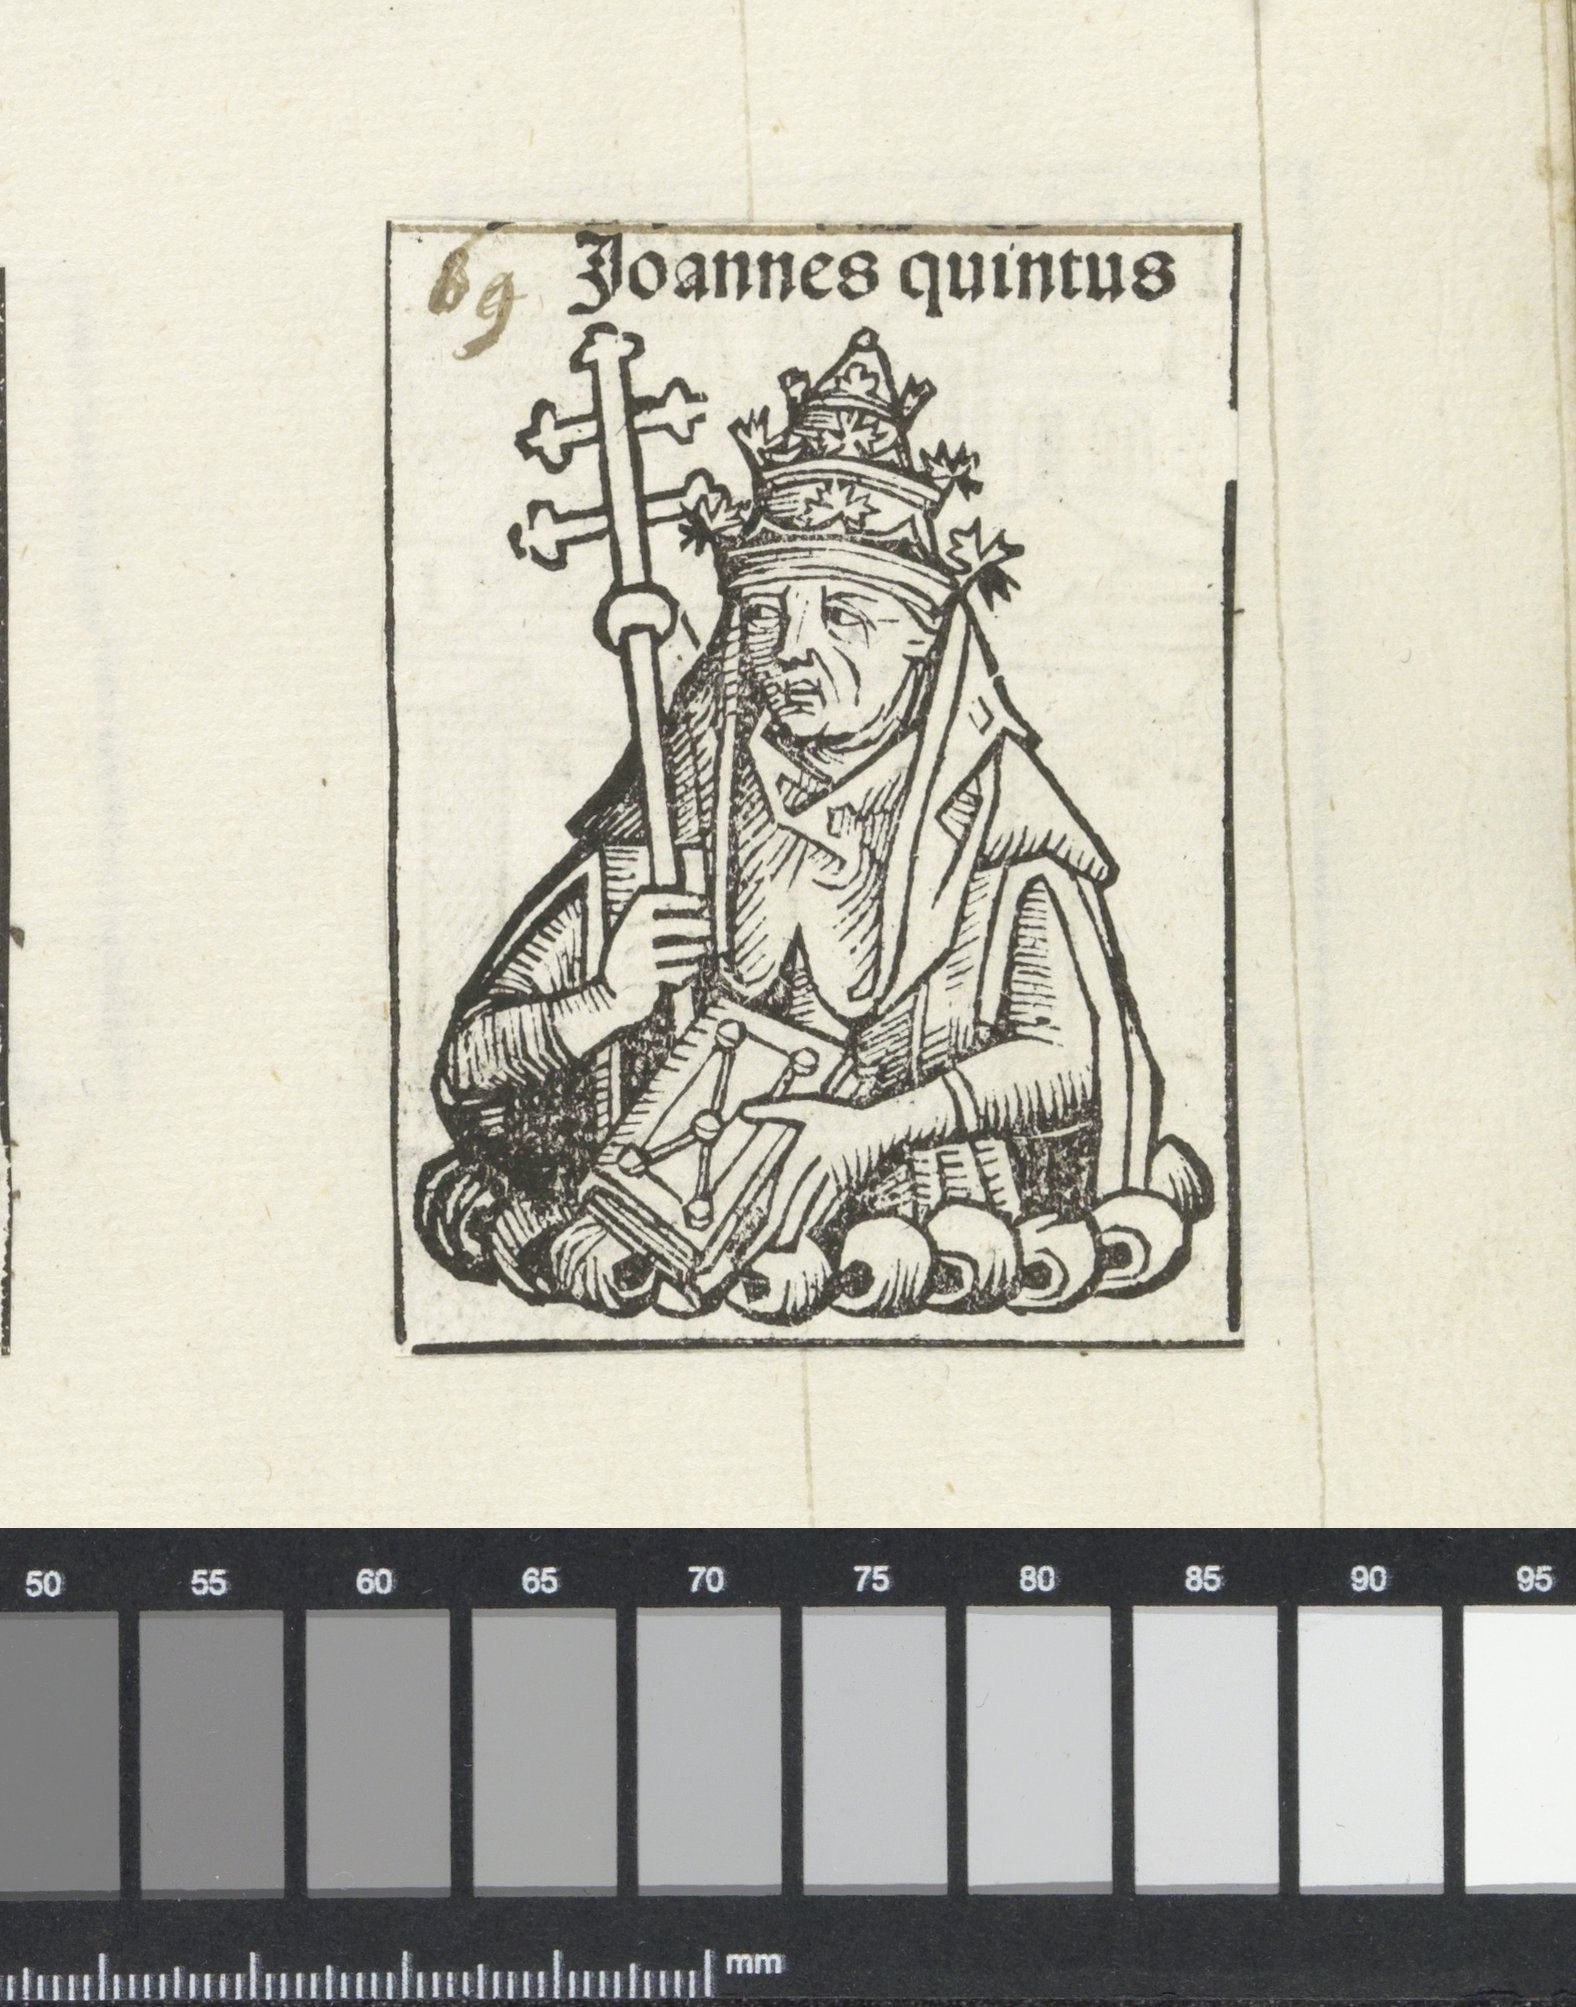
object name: album leaf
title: Liber Chronicarum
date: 1493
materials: paper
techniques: letterpress printing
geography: nuremberg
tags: pope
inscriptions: inscription: ‘69’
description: Een bloemkelk met een paus. Hij draagt een tiara en heeft een bijbel en een staf met een dubbel kruis in zijn handen. De voorstelling is onderdeel van de opeenvolging pausen in de Liber Chronicarum. De tekst identificeert de man als Johannes V. De prent maakt deel uit van een album.